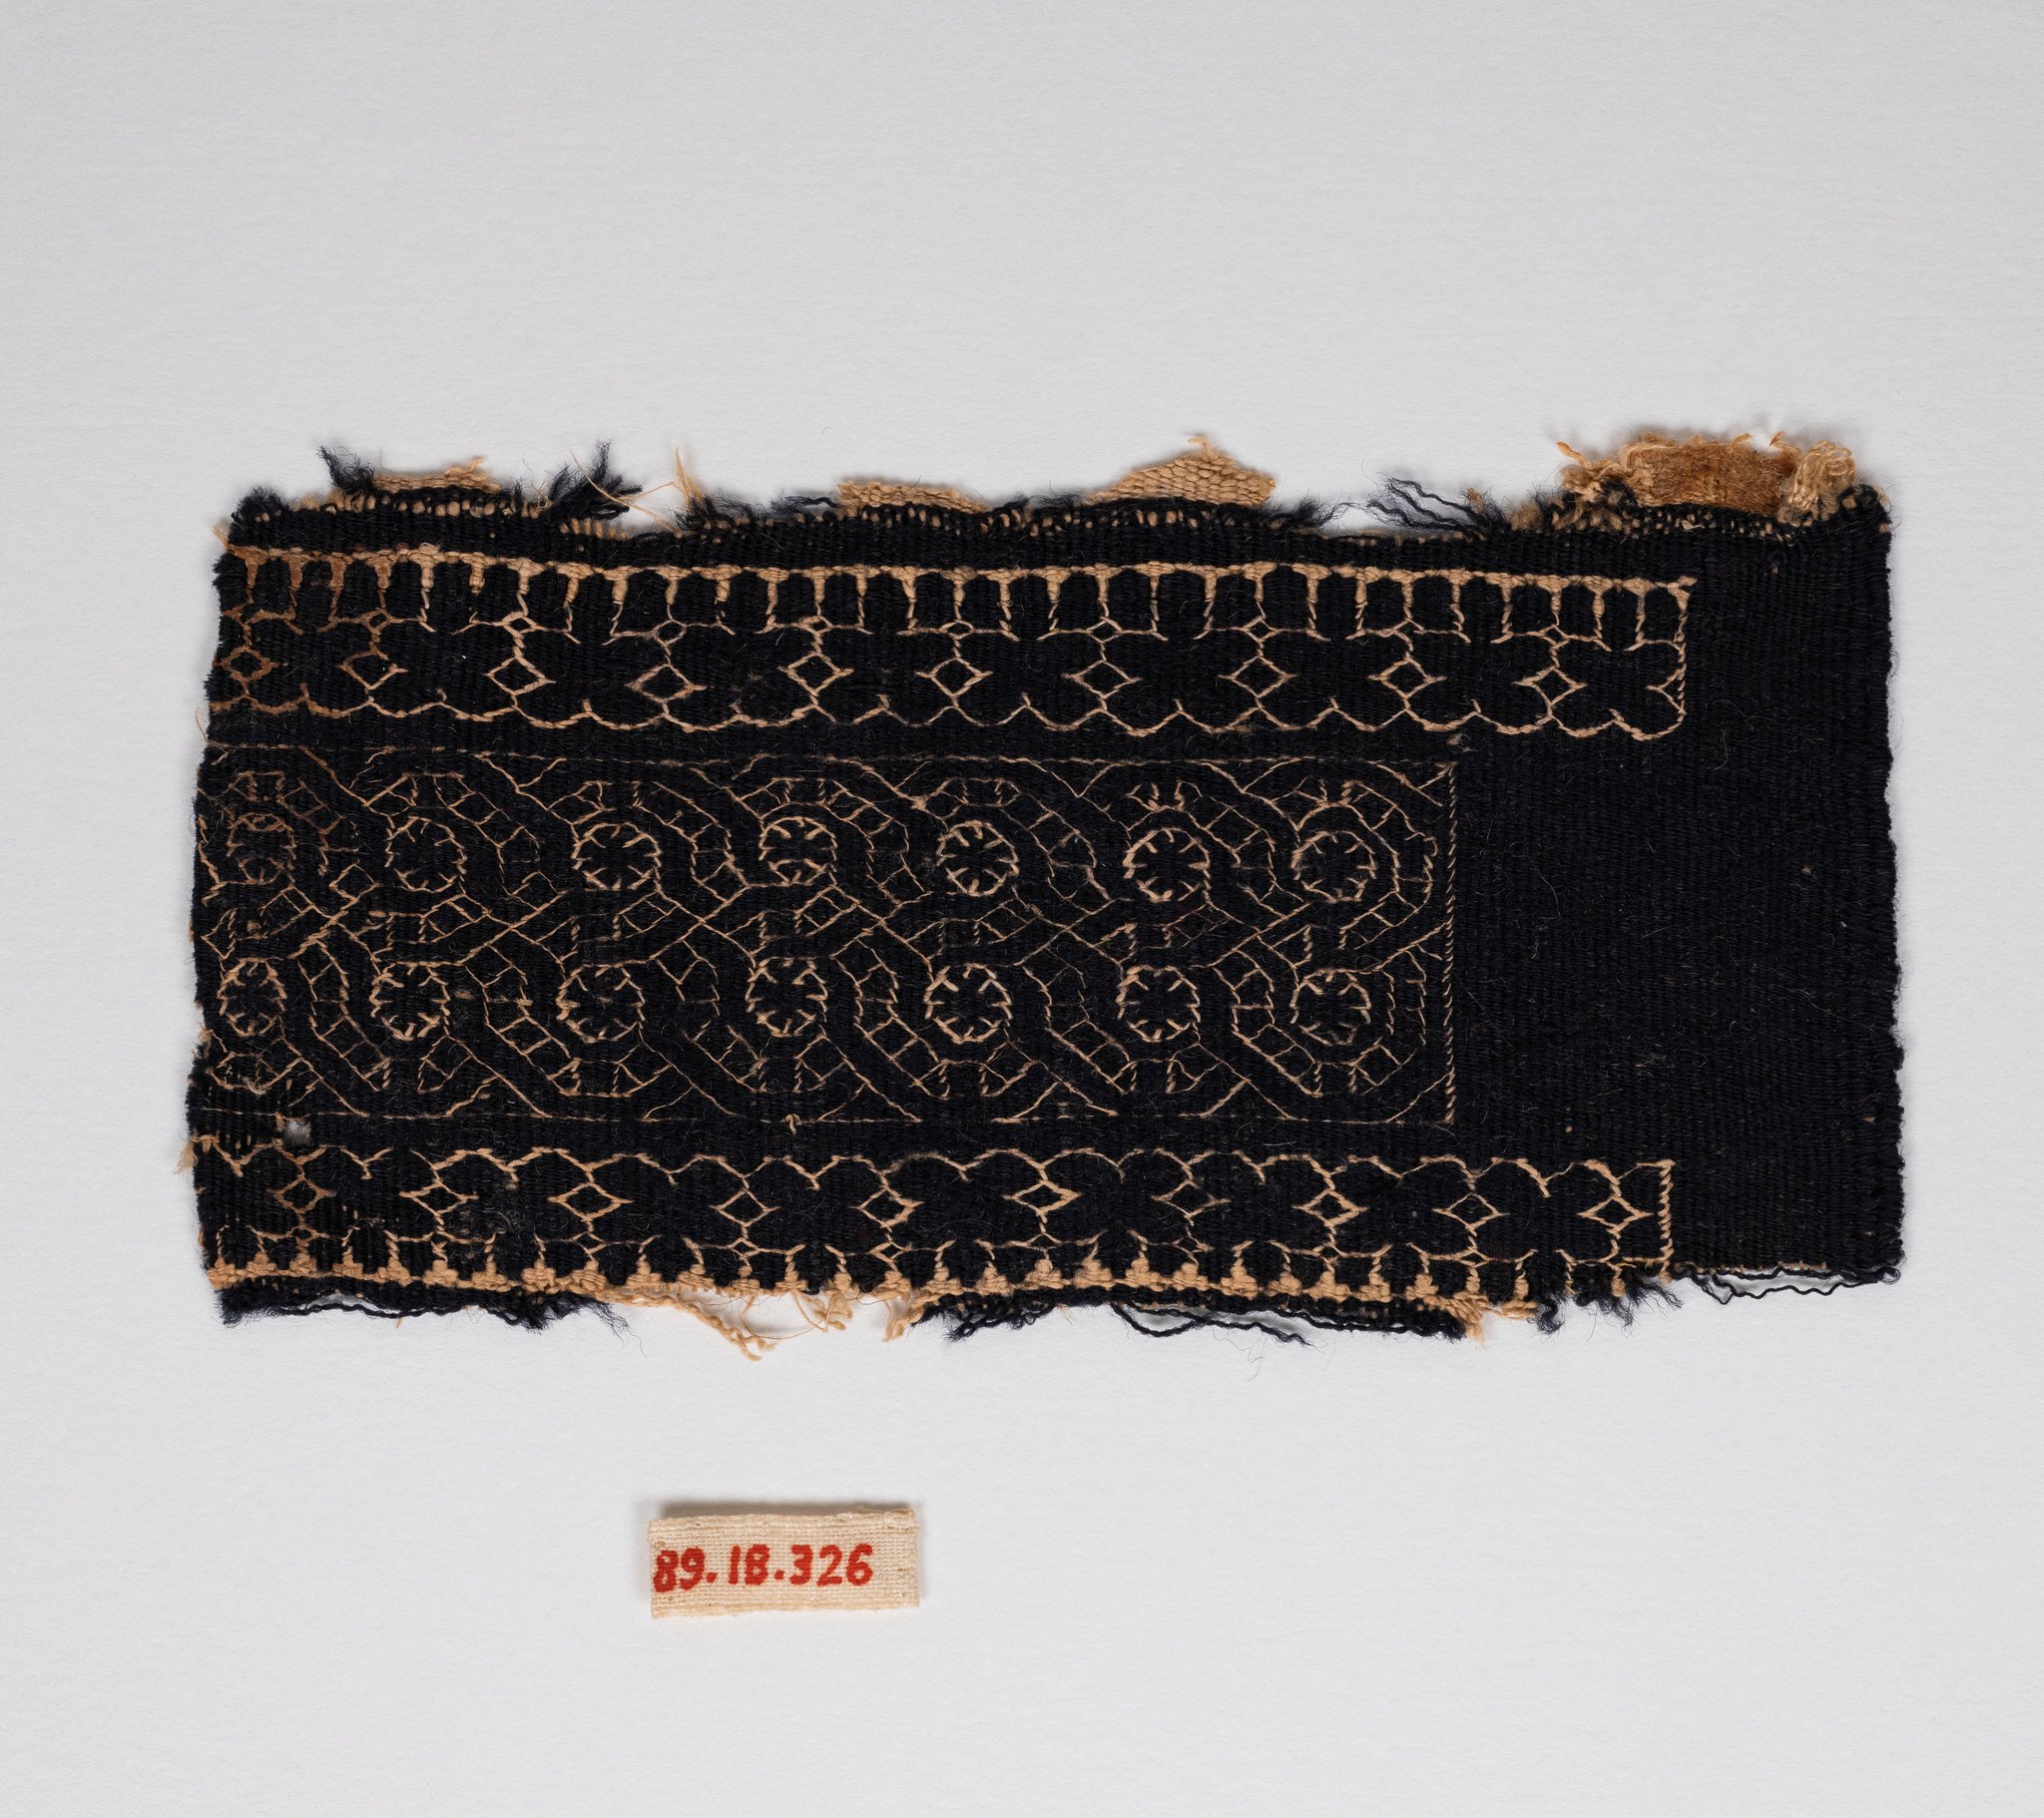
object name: textile fragment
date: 201-400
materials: linen, wool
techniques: weave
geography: egypt